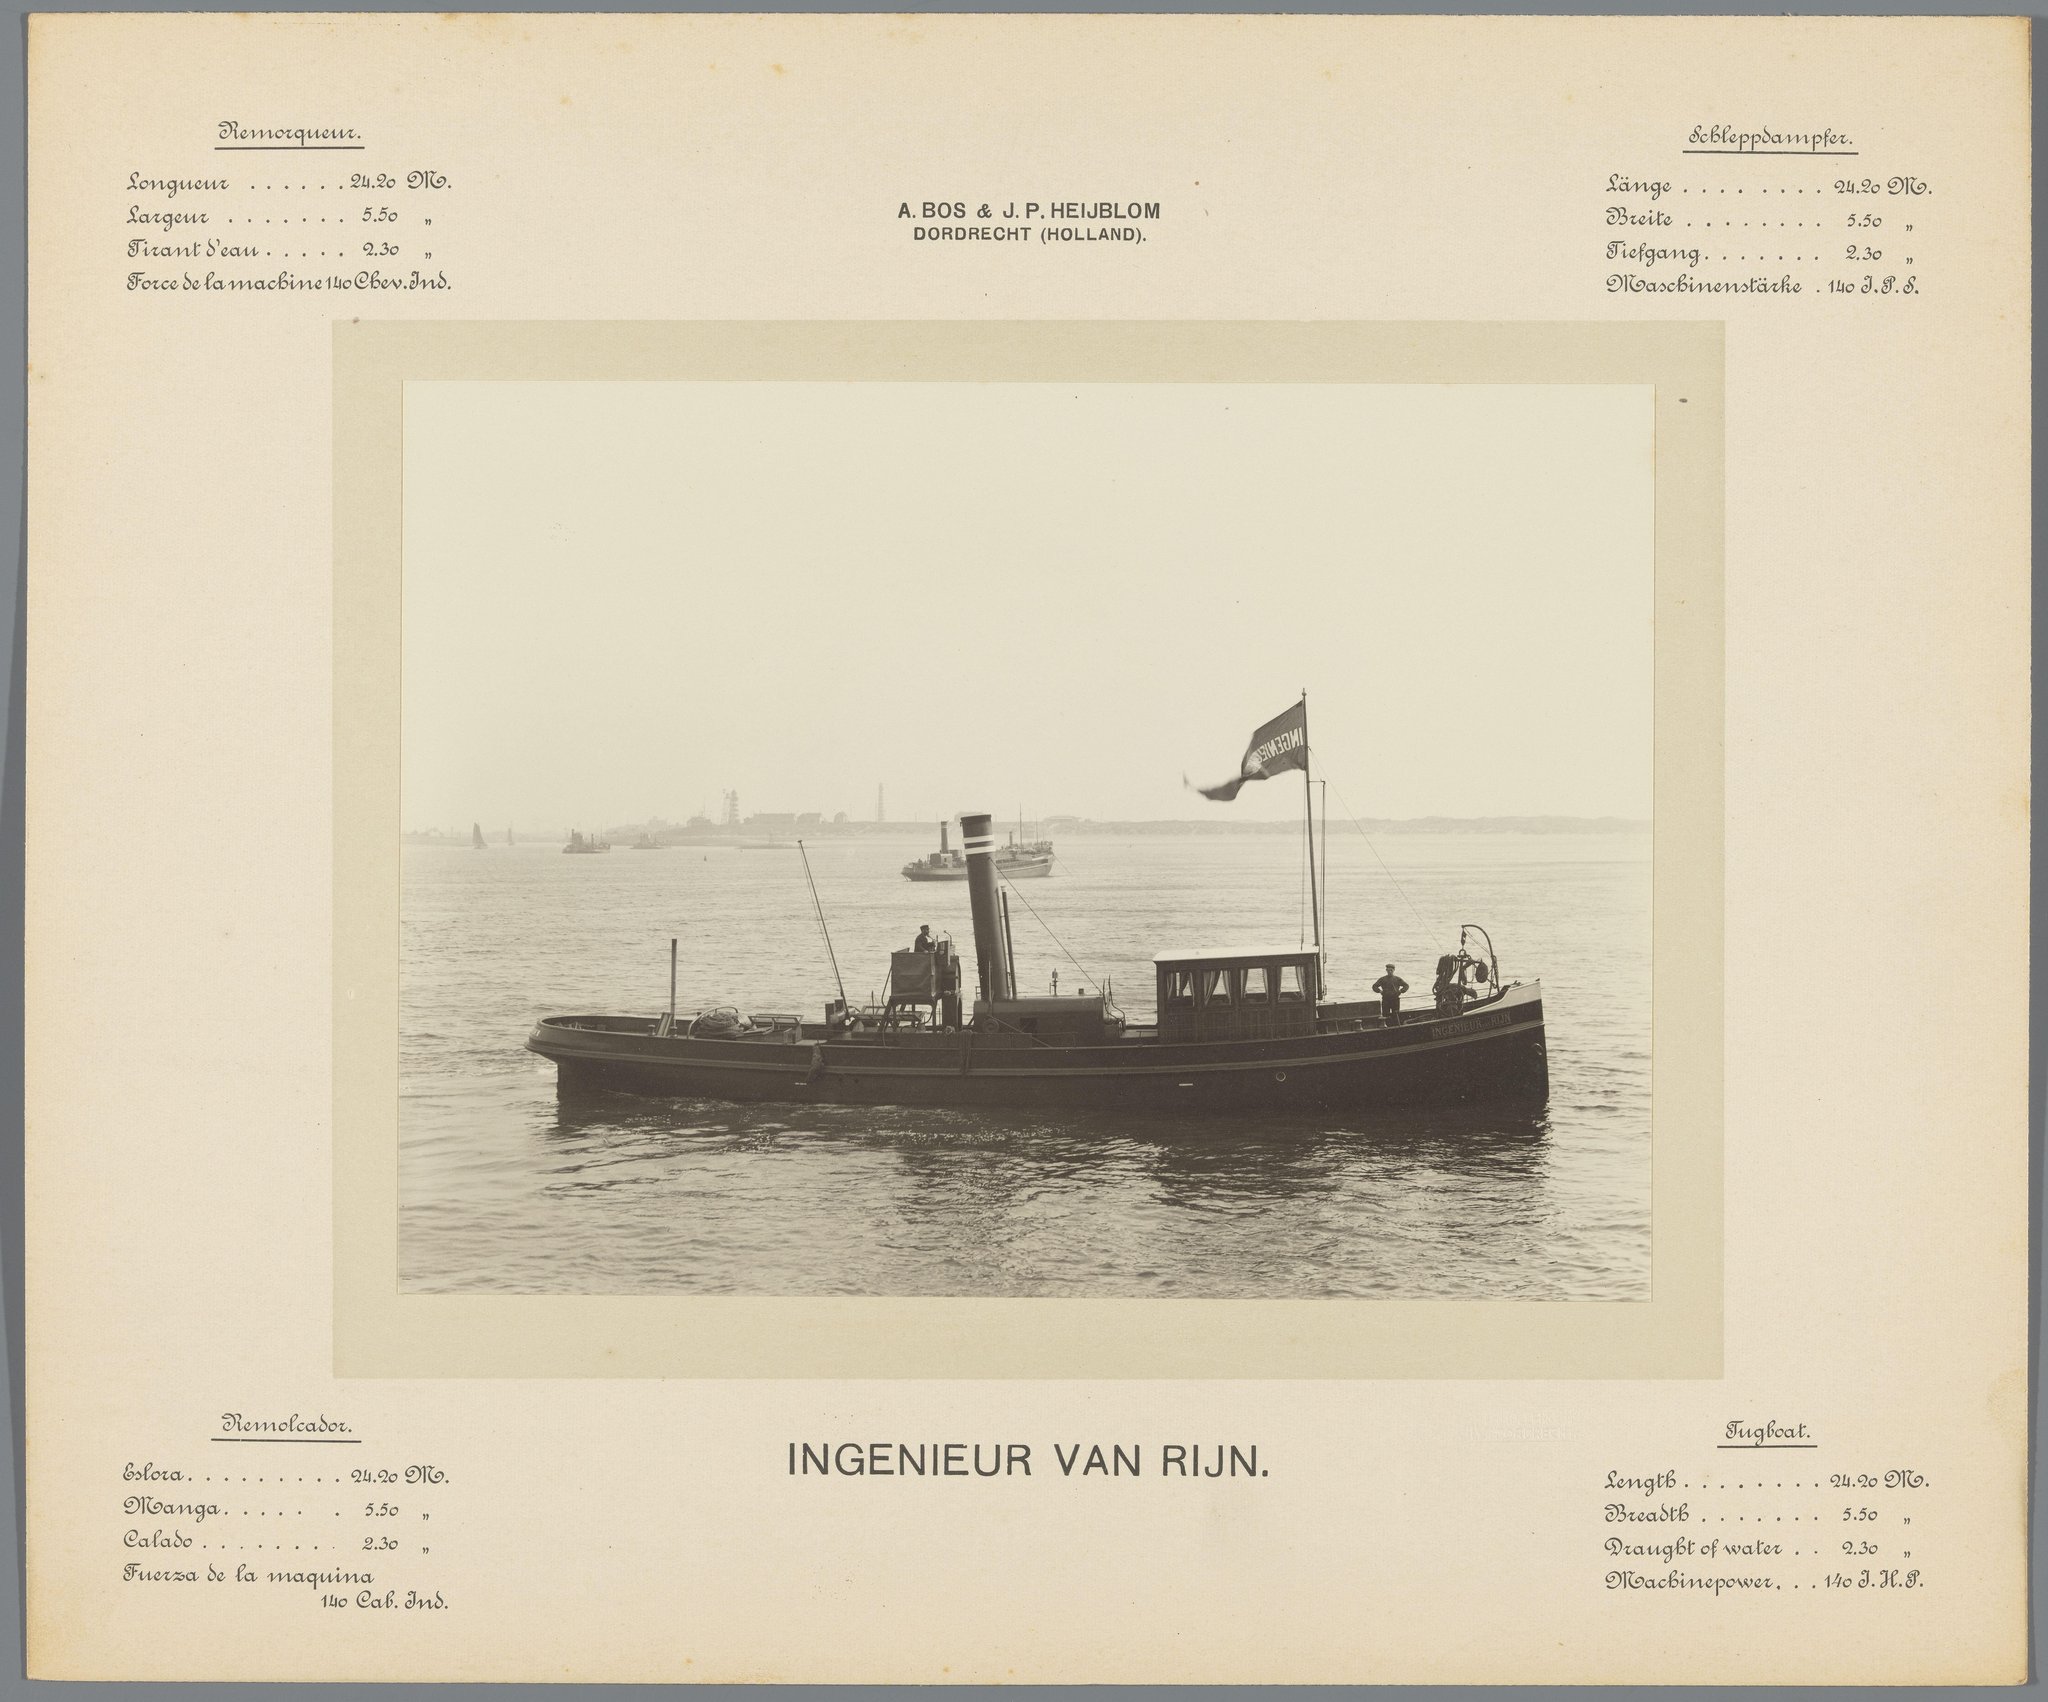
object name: photograph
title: Ingenieur van Rijn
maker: henricus jacobus tollens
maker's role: painter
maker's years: 1864-1936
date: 1900-1910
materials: cardboard, photographic support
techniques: gelatin silver print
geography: dordrecht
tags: machine driven by steam, steamship, motorship (+ propulsion of vehicle, ship, etc. by steam), tug, pusher tug (+ propulsion of vehicle, ship, etc. by steam), dredge, dredging machine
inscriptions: name: ‘H.J. Tollens C. Hzn. Dordrecht’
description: Sleepboot Ingenieur van Rijn. Foto geplakt op karton met technische informatie over het schip in Duits, Frans, Spaans en Engels. Onderdeel van de map met 44 foto's van baggerschepen van de firma A. Bos & J.P. Heijblom te Dordrecht.